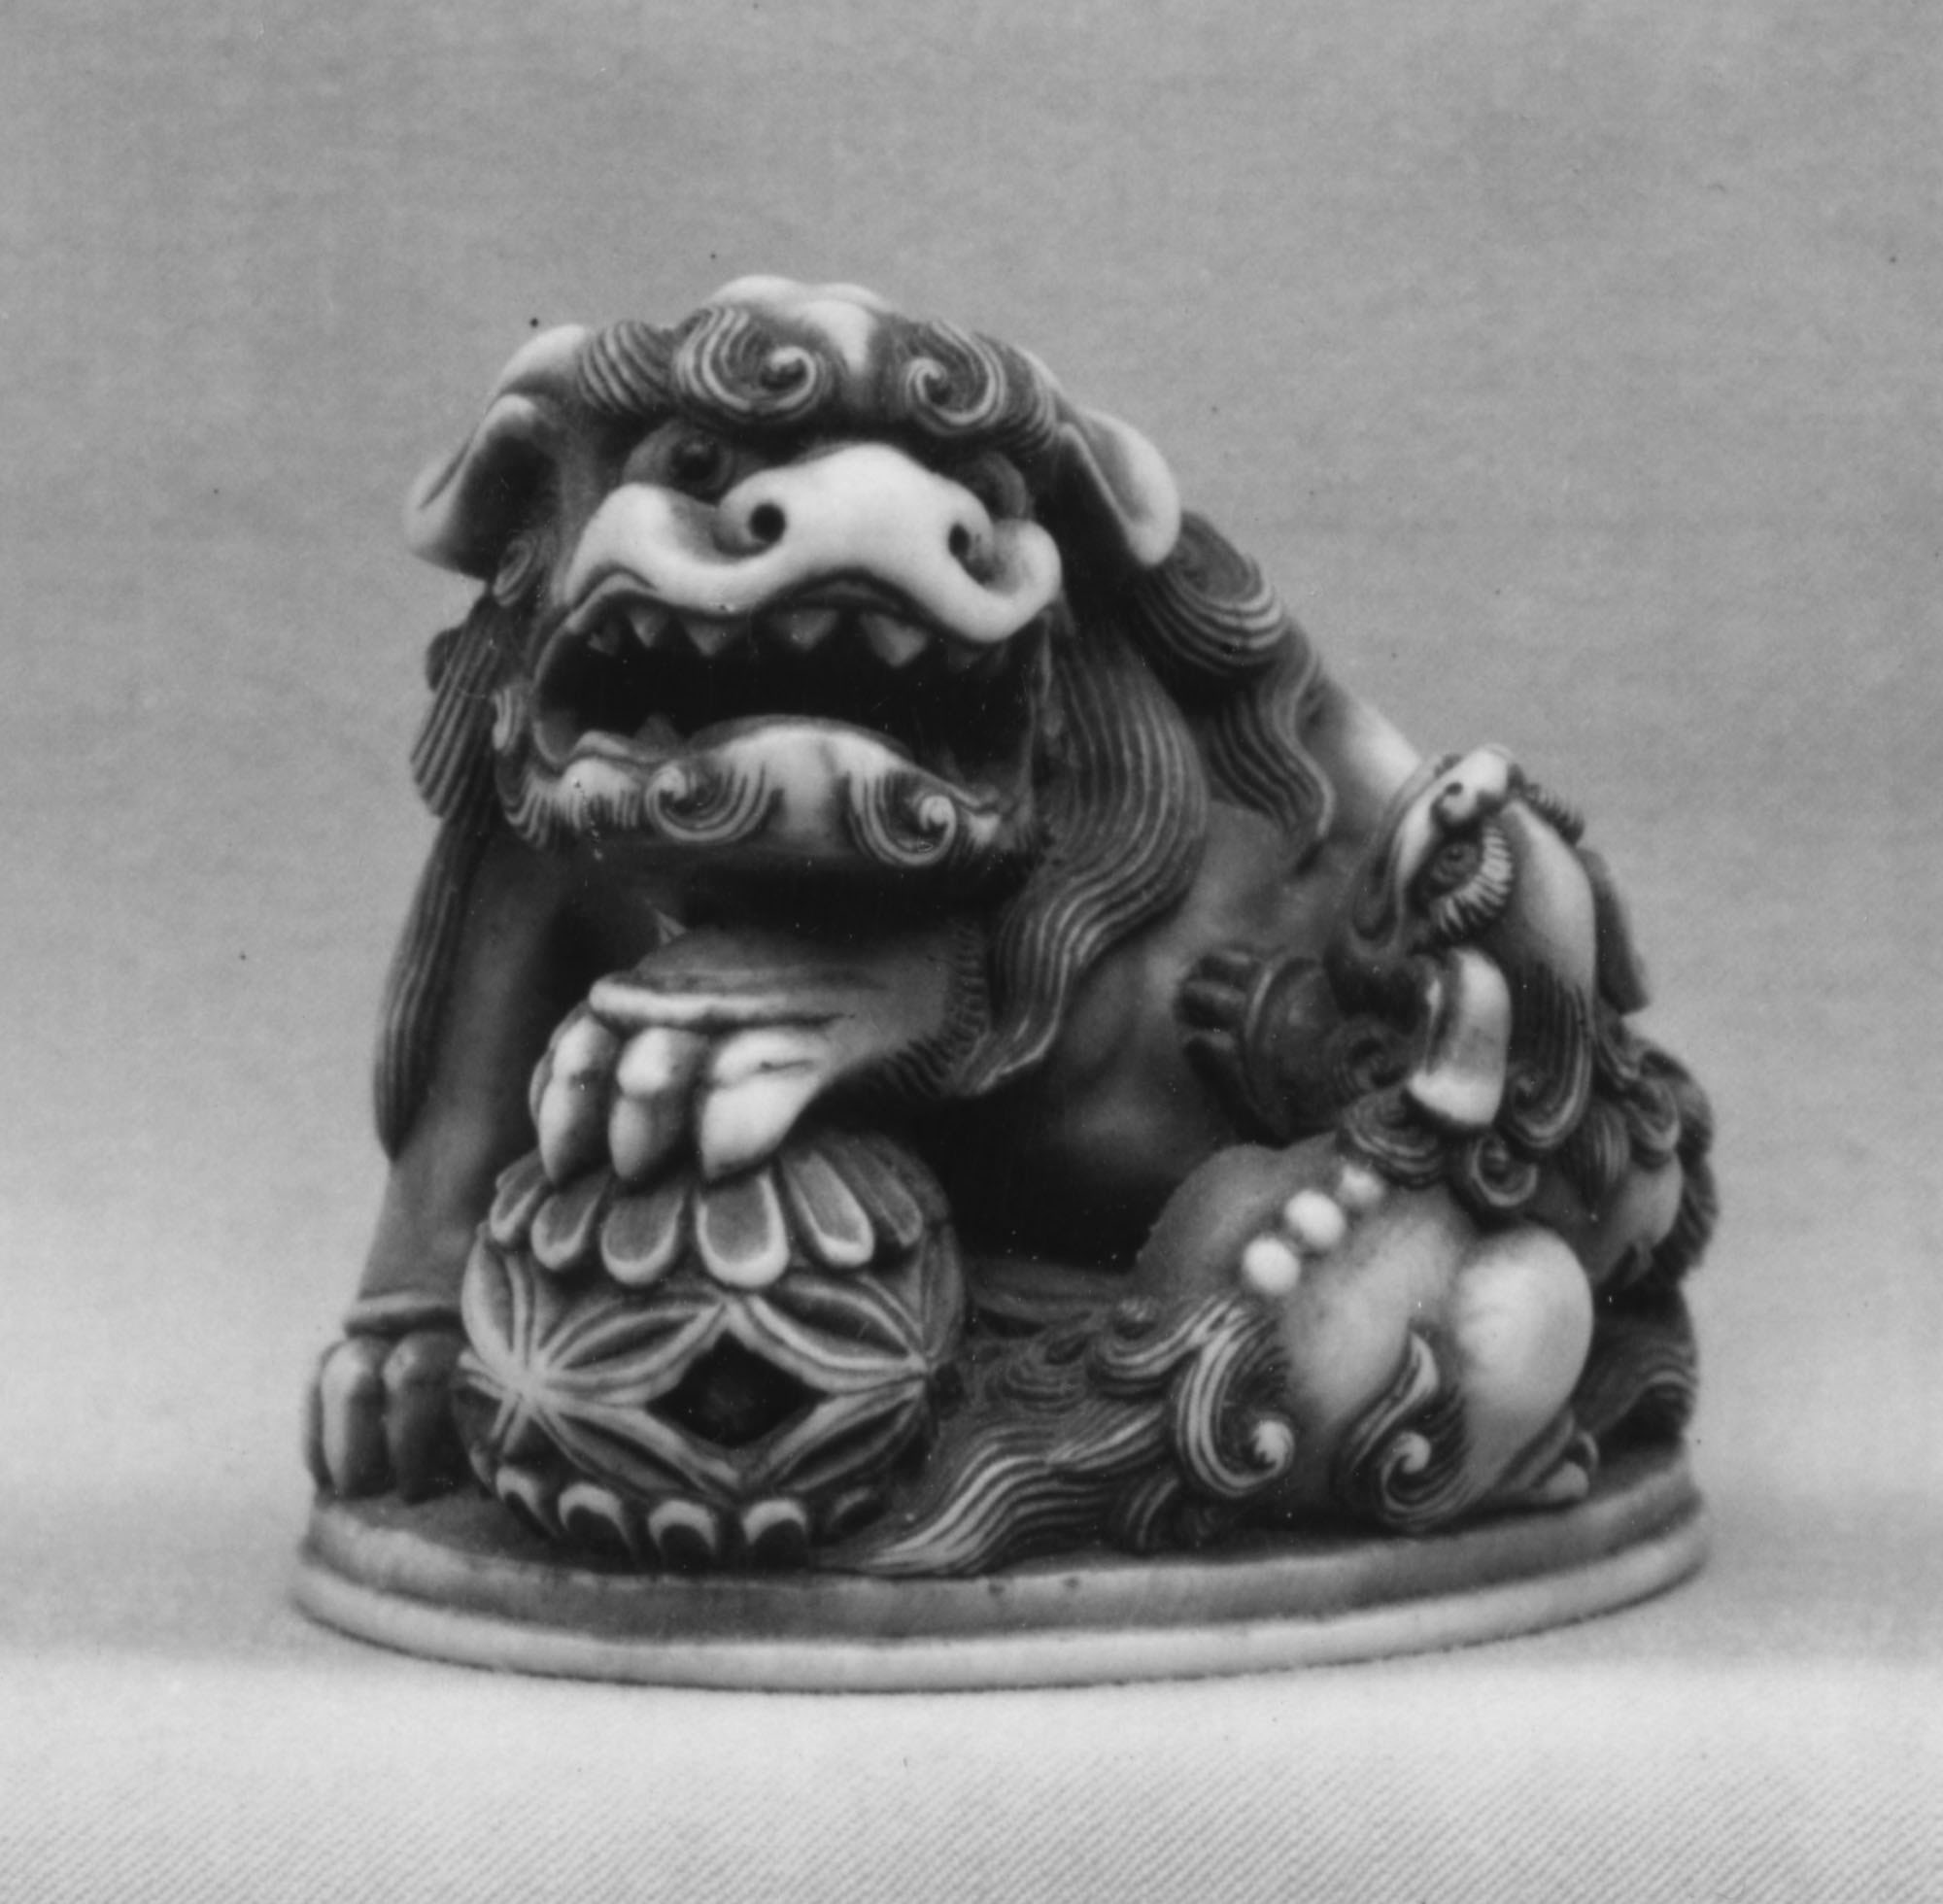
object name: netsuke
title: Netsuke of Lion with Ball and Cub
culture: japanese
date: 1801-1900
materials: ivory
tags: lions